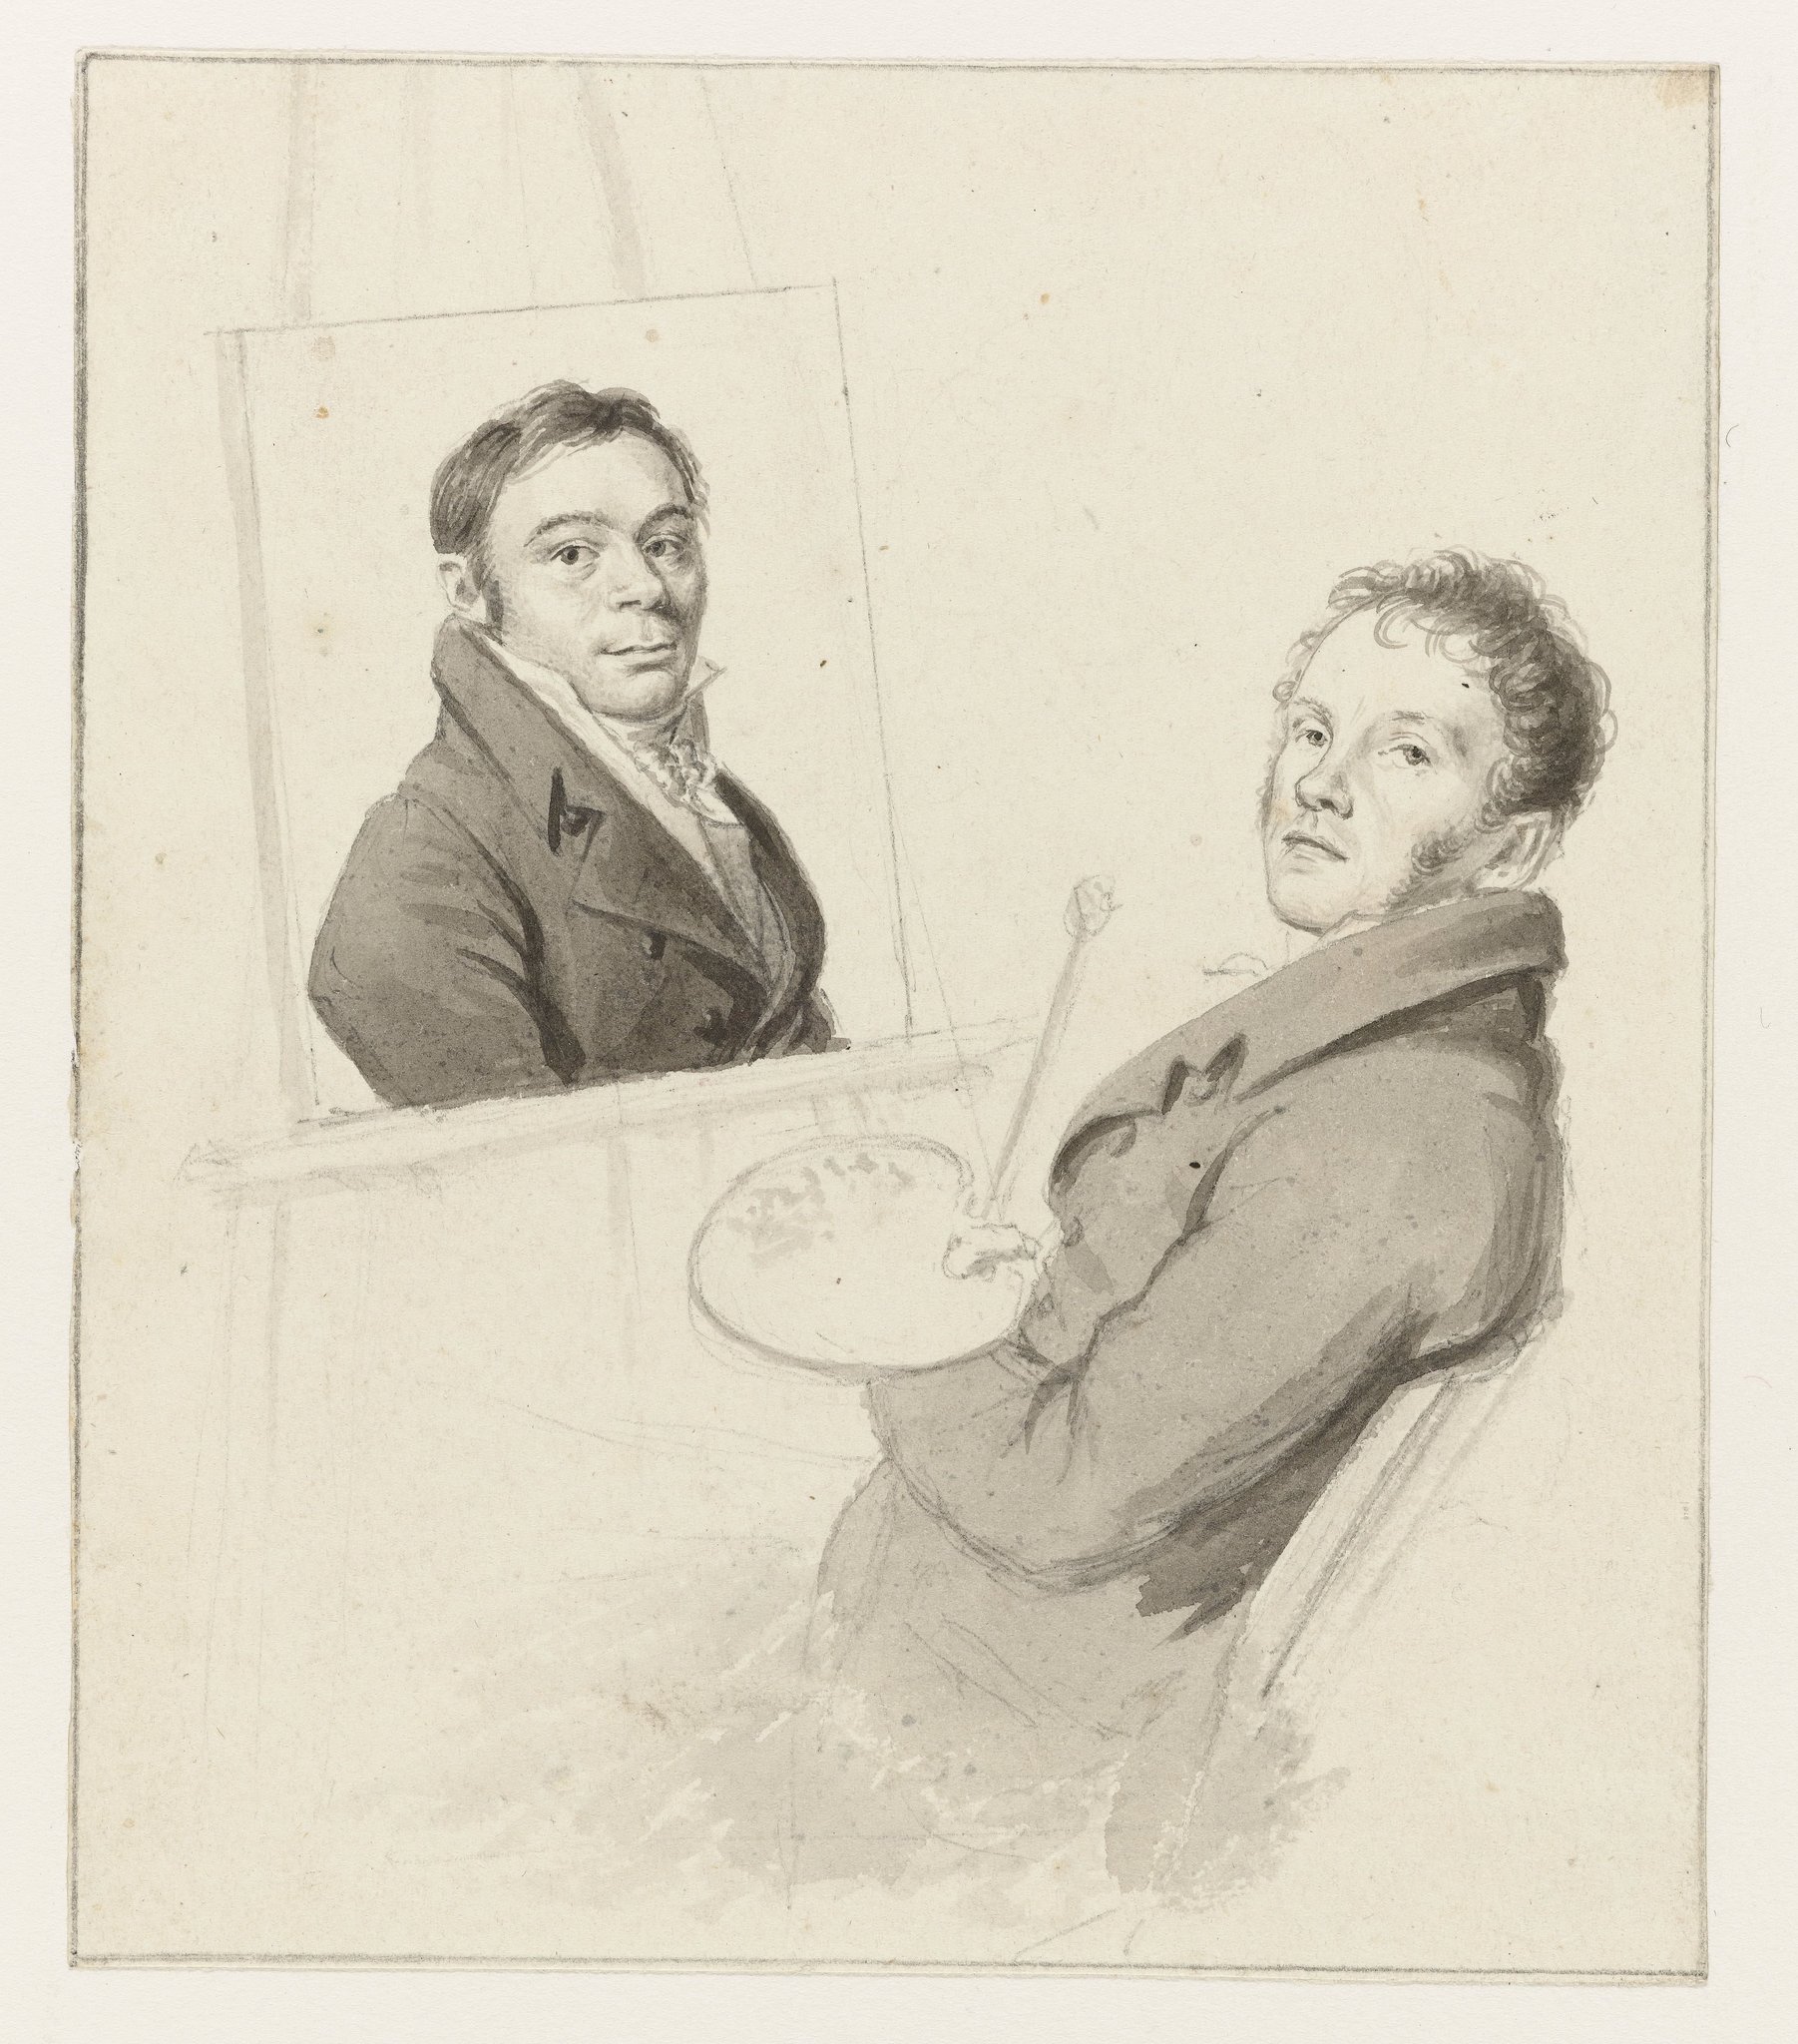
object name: drawing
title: Portret van Christiaen Andriessen die een portret van Izaak Riewert Schmidt schildert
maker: hendrik willem caspari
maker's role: draughtsman, print maker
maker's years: 1770-1829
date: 1780-1829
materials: paper, pencil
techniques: brush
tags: amsterdam, print maker, draughtsman, christiaan andriessen, delft, izaak riewert schmidt, historical persons, portrait, self-portrait of painter, portrait, self-portrait of artist, portrait, self-portrait of draughtsman